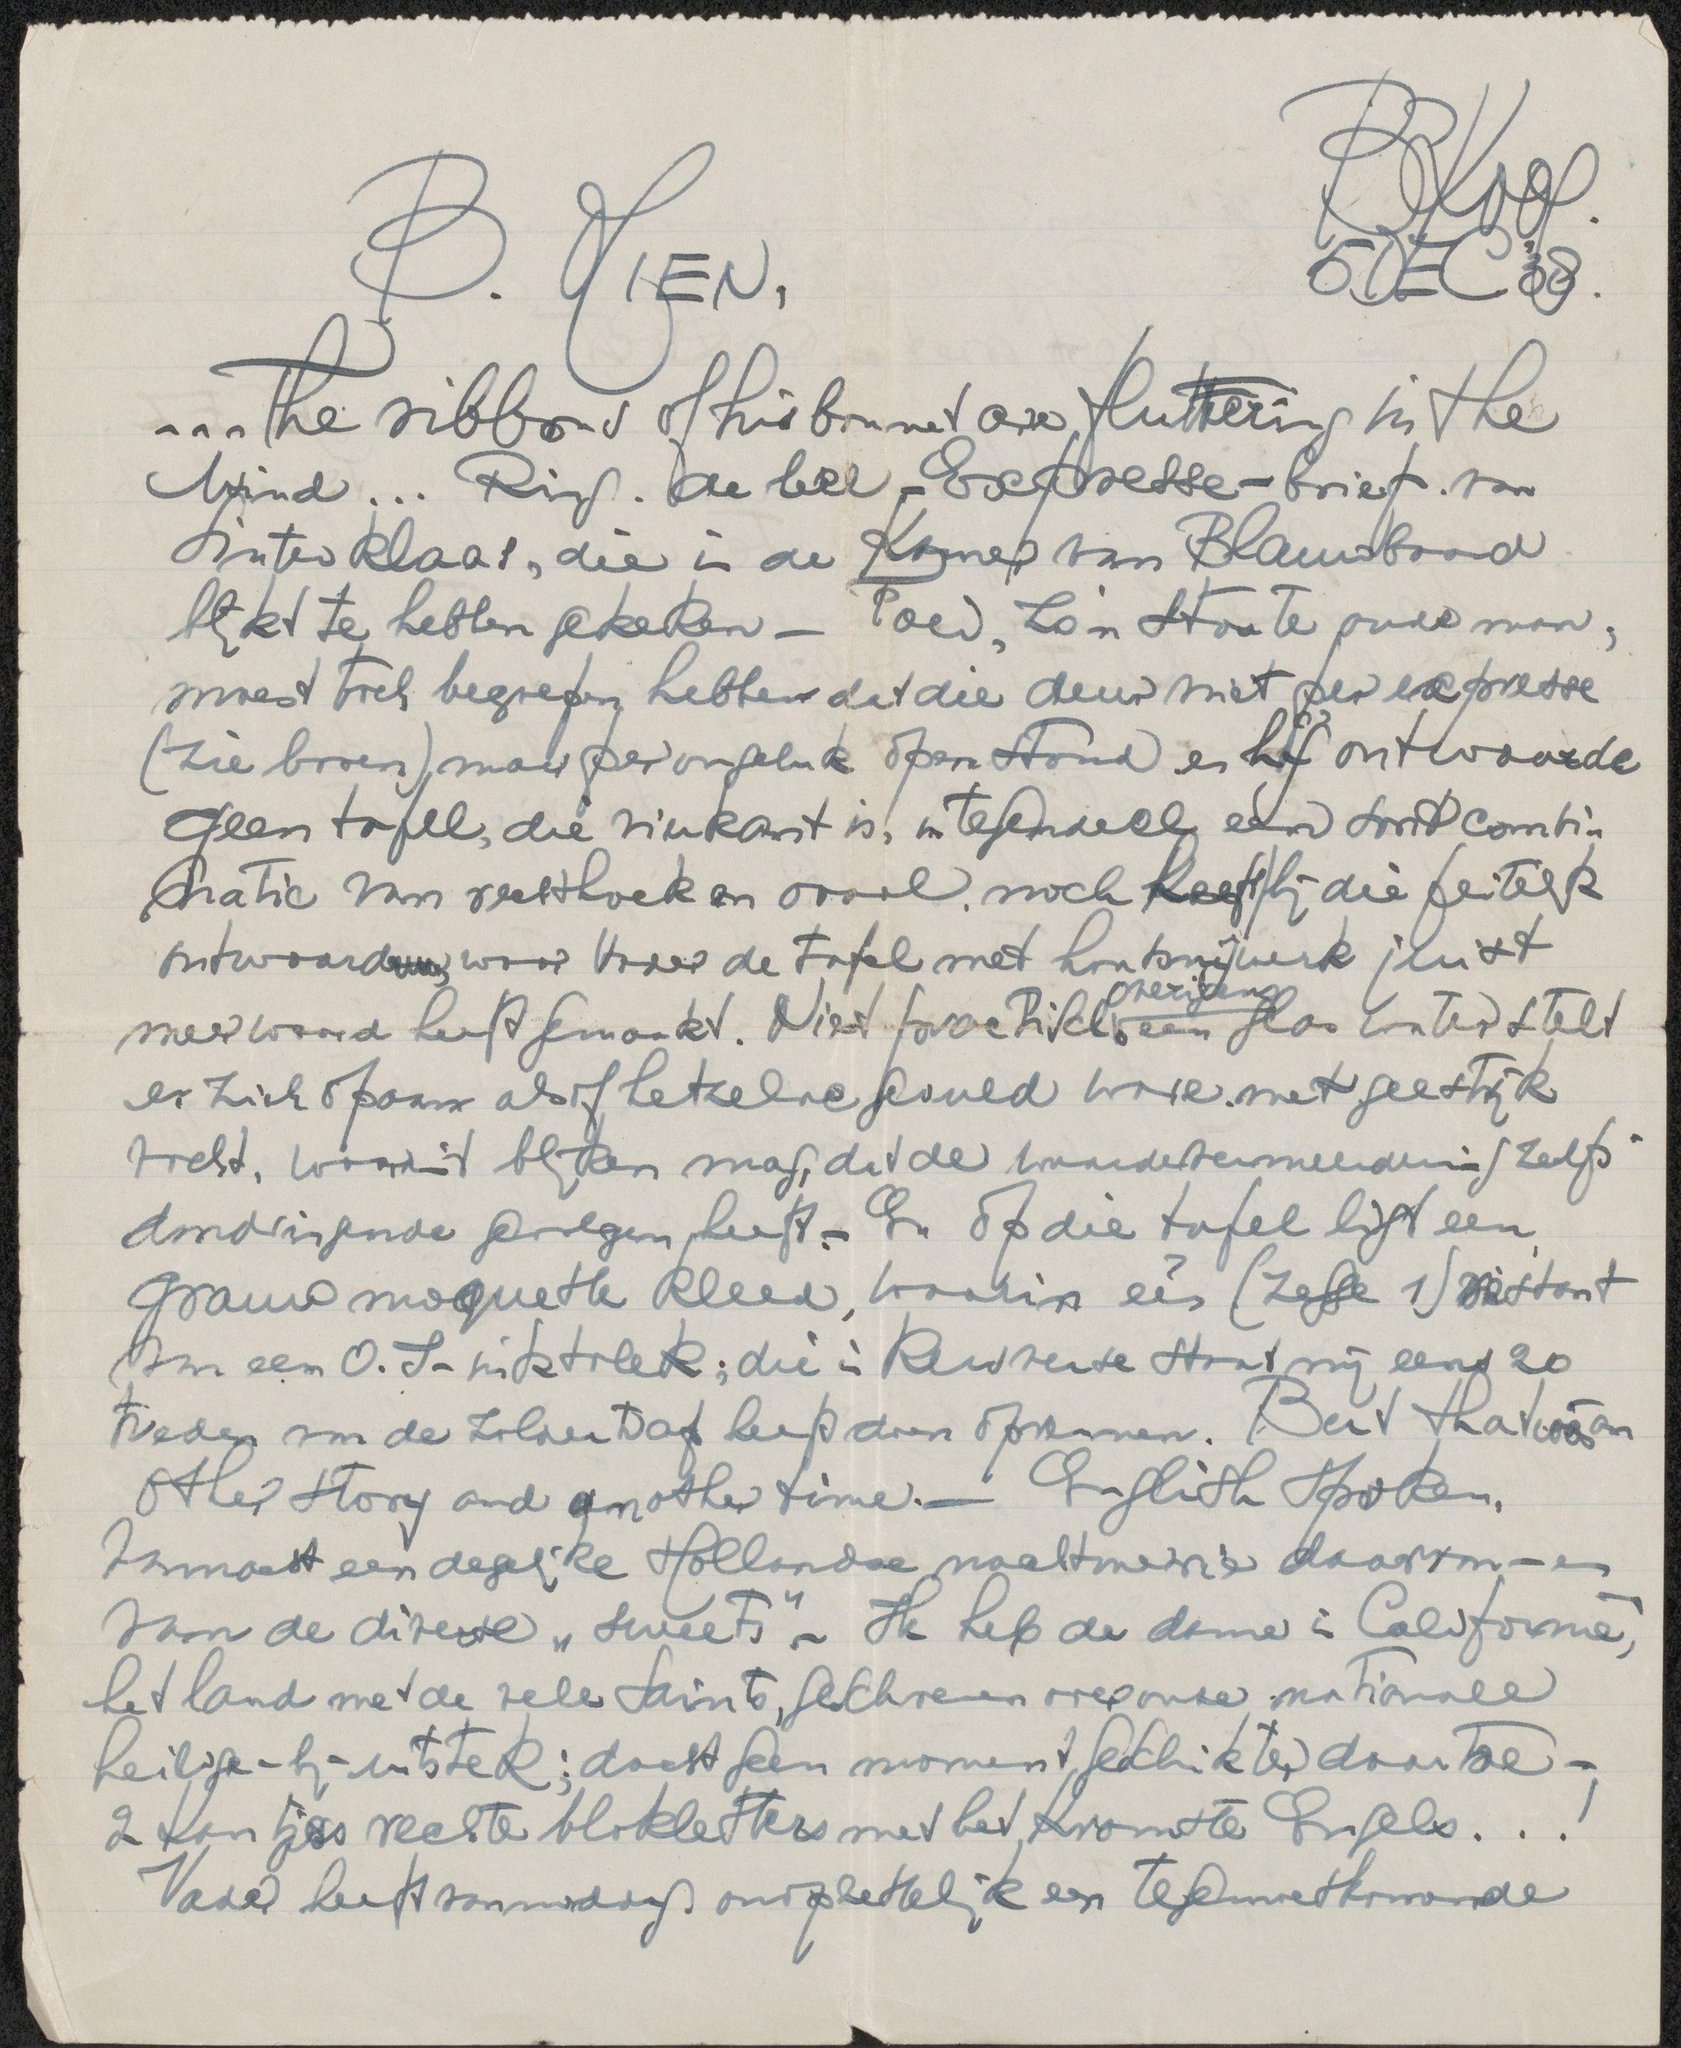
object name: letter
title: Brief aan Mien Cambier van Nooten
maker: dick ket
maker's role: draughtsman, print maker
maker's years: 1902-1940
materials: ink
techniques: pen, writing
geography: bennekom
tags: arnhem, draughtsman, mien cambier van nooten, amsterdam, jos croïn, print maker, jan greshoff, germ de jong, delft, jan van herwijnen, haarlem, dollmaker, textile artist, nelly johanna hagelen-schilt, drawing, painting (including book-illumination, miniature-painting)